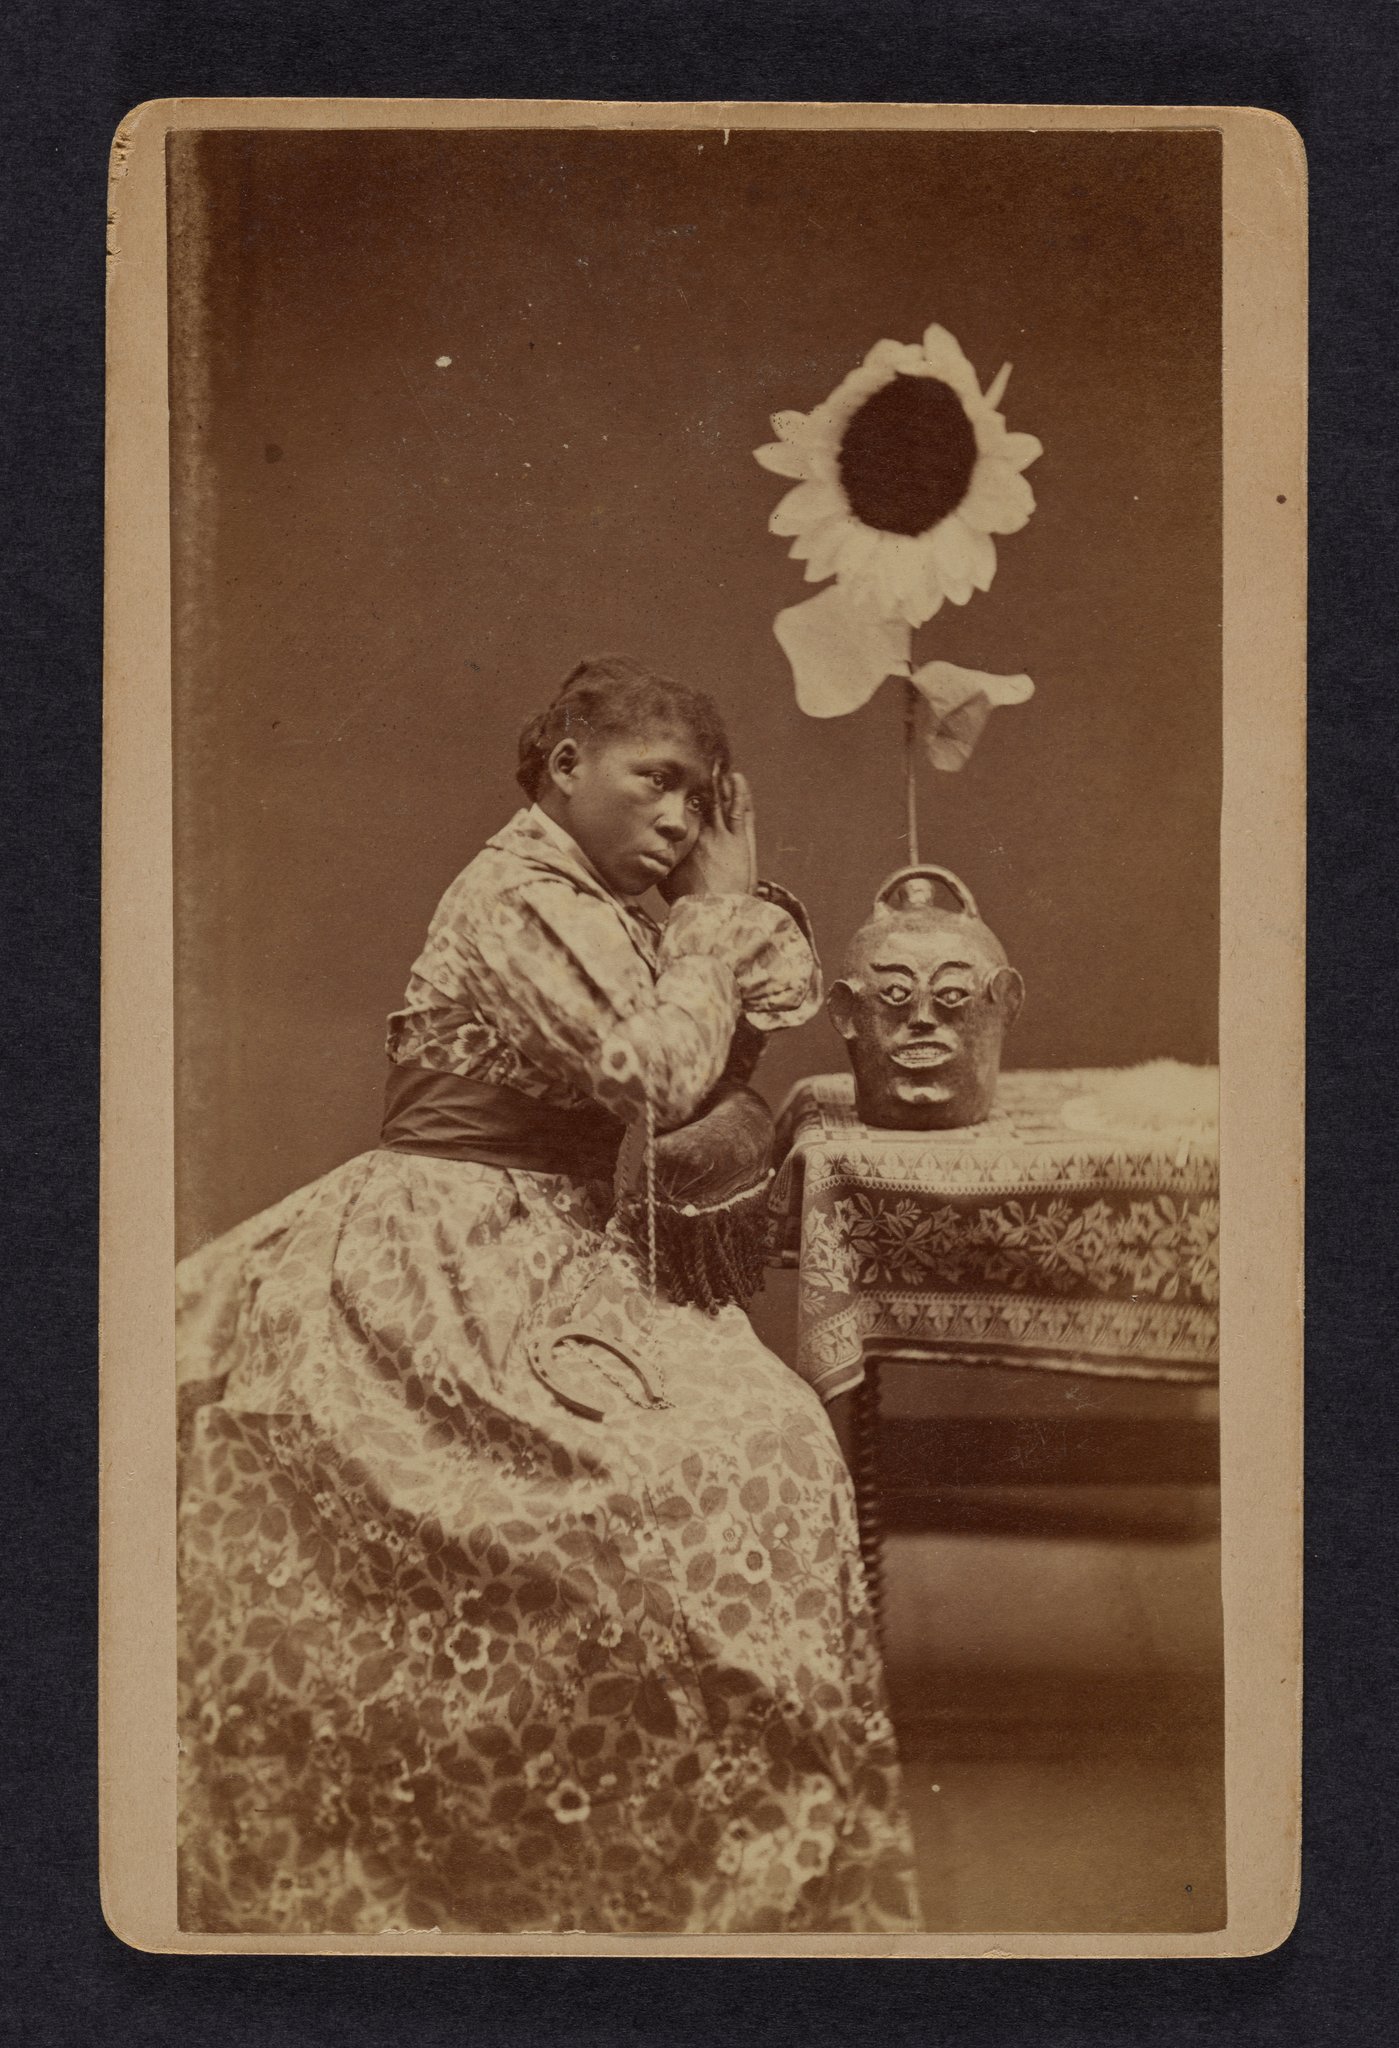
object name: photograph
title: "The Wilde Woman of Aiken," from the "Aiken and Vicinity" series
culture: american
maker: james a. palmer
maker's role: artist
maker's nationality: irish-american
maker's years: 1825-1896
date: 1882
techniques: albumen silver print, glass negative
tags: women,flowers,jugs